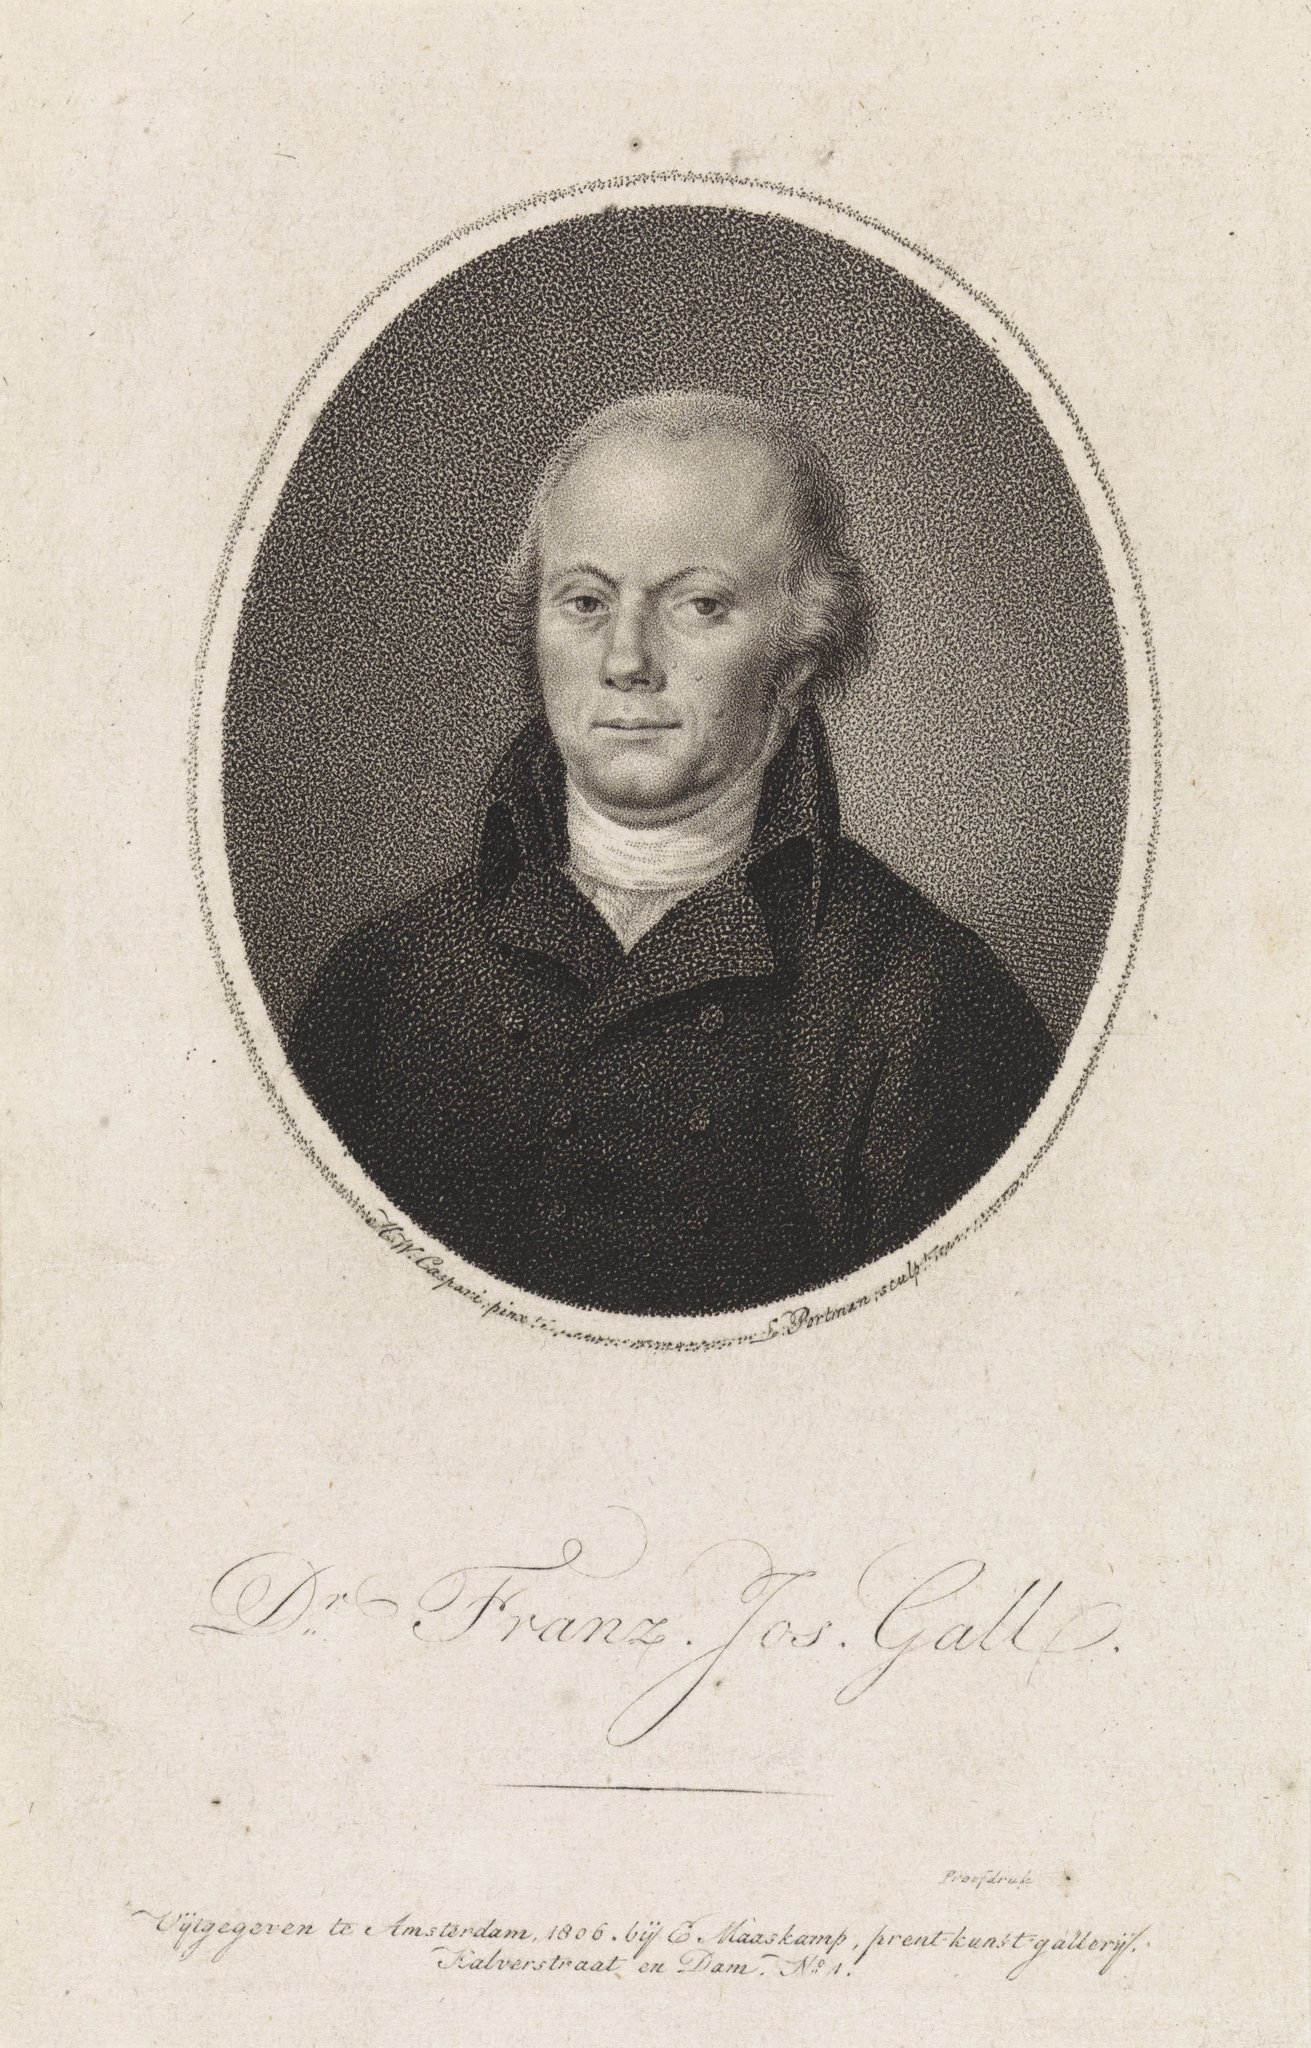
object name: print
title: Portret van fysioloog Franz Josef Gall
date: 1806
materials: paper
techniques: stippled etching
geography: amsterdam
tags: pforzheim, fysioloog, anatoom, franz joseph gall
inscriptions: collector's mark: Lugt 2228